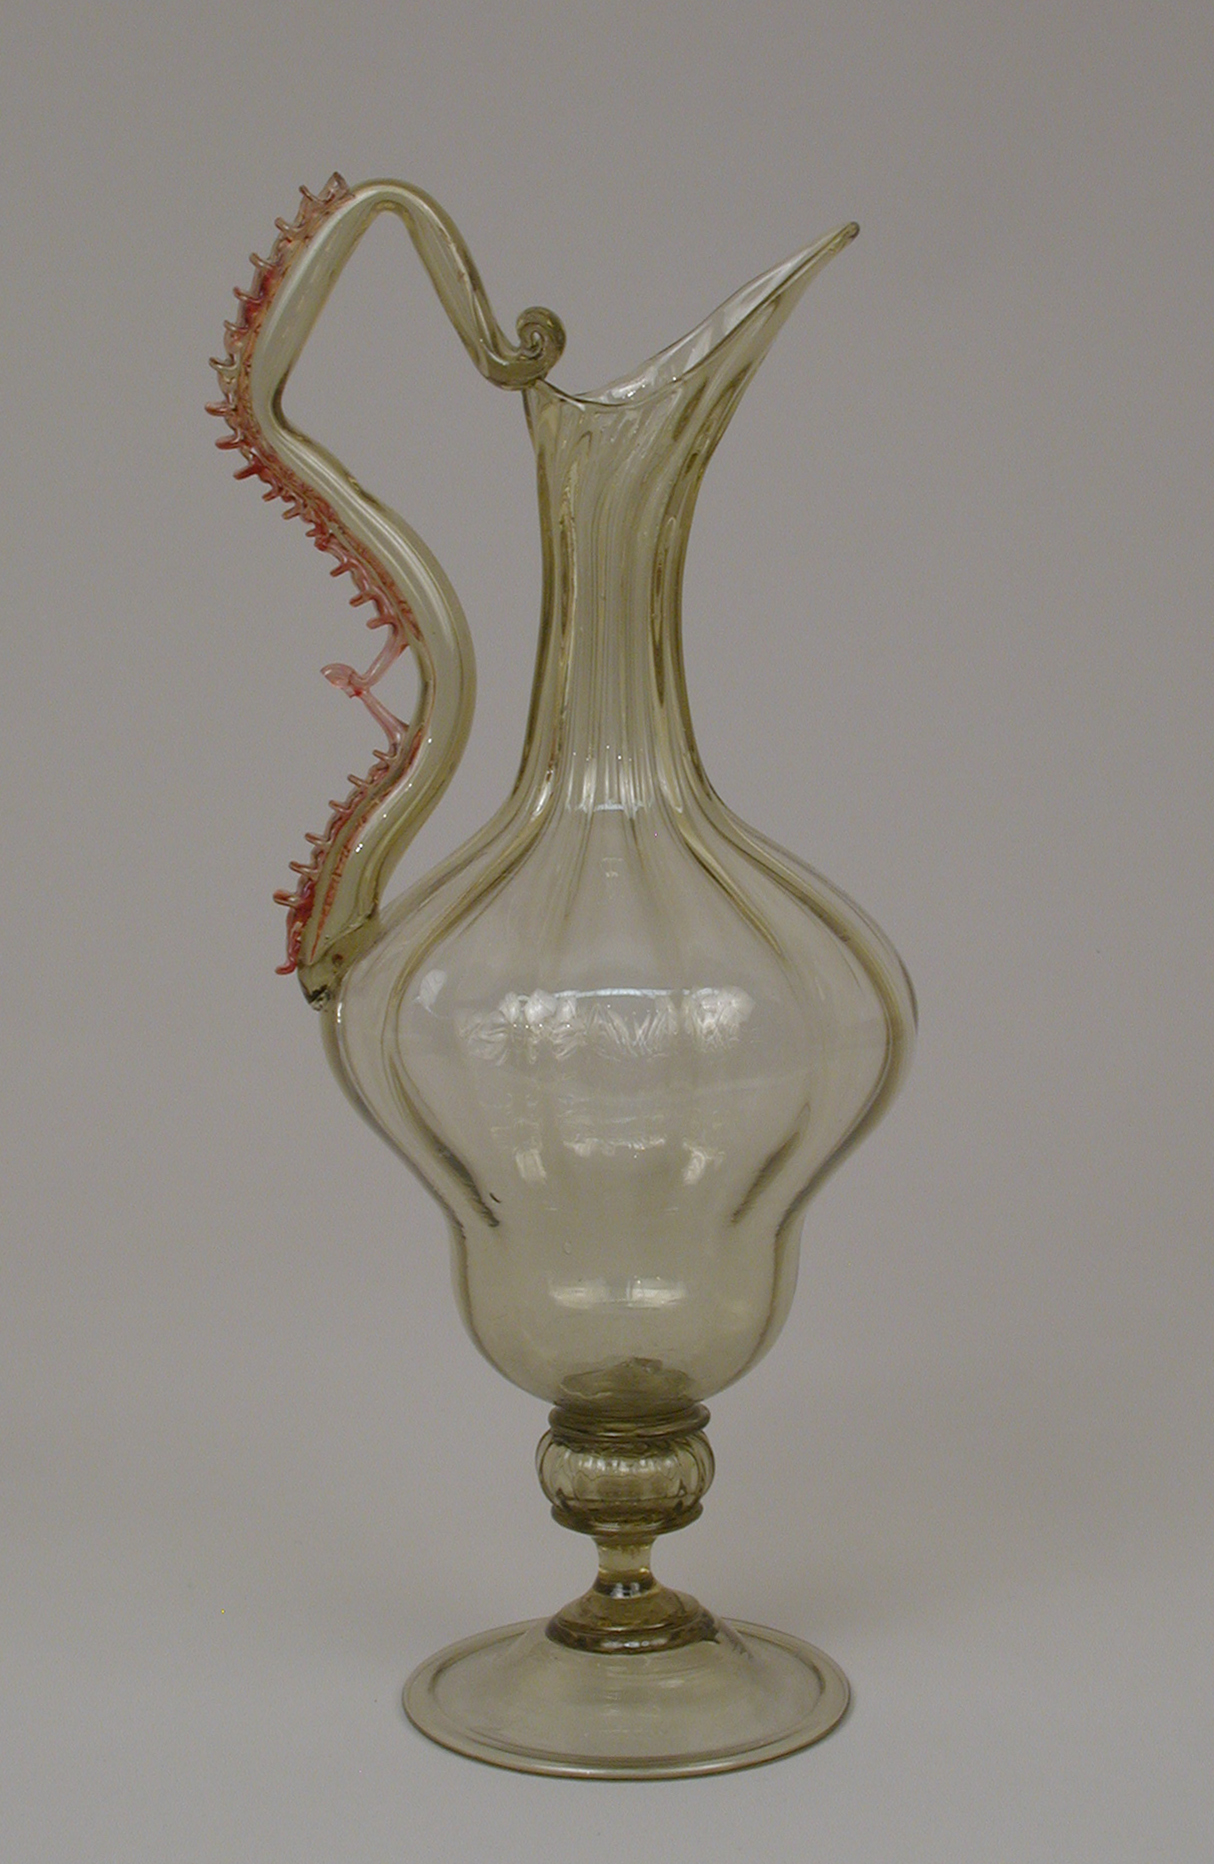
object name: ewer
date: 1860-1880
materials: glass